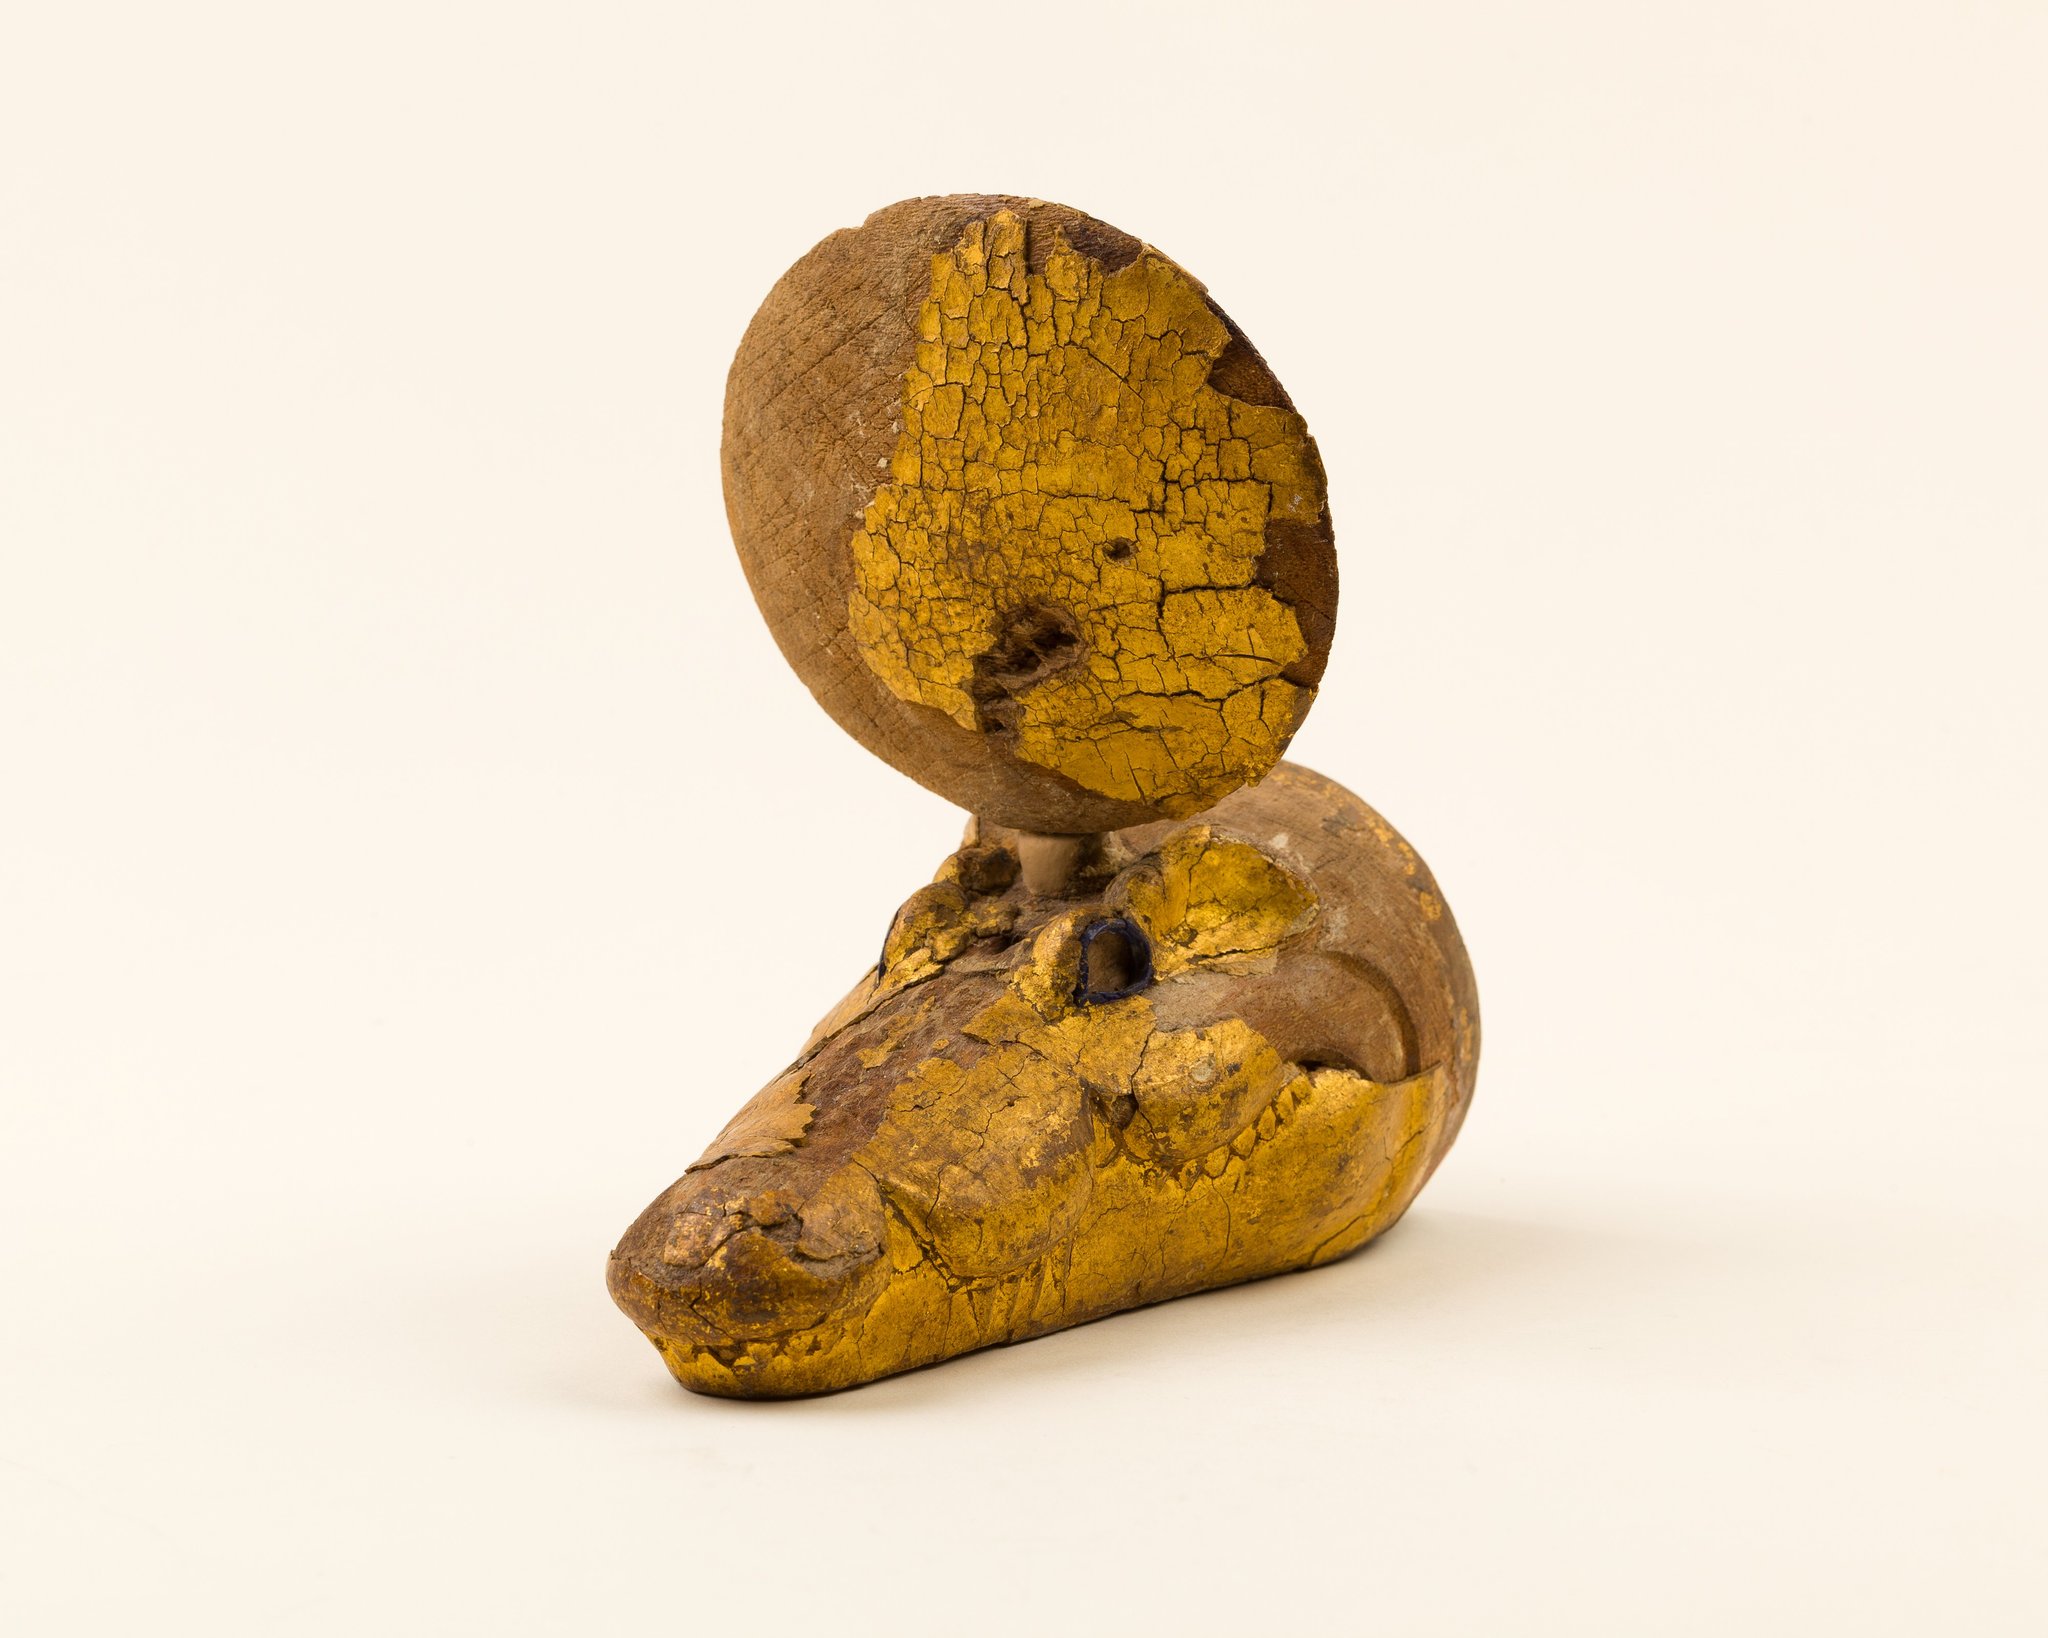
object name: crocodile head, mummy mask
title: Mask for a crocodile mummy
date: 664-630 BCE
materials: gold leaf, wood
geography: egypt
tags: masks,crocodiles